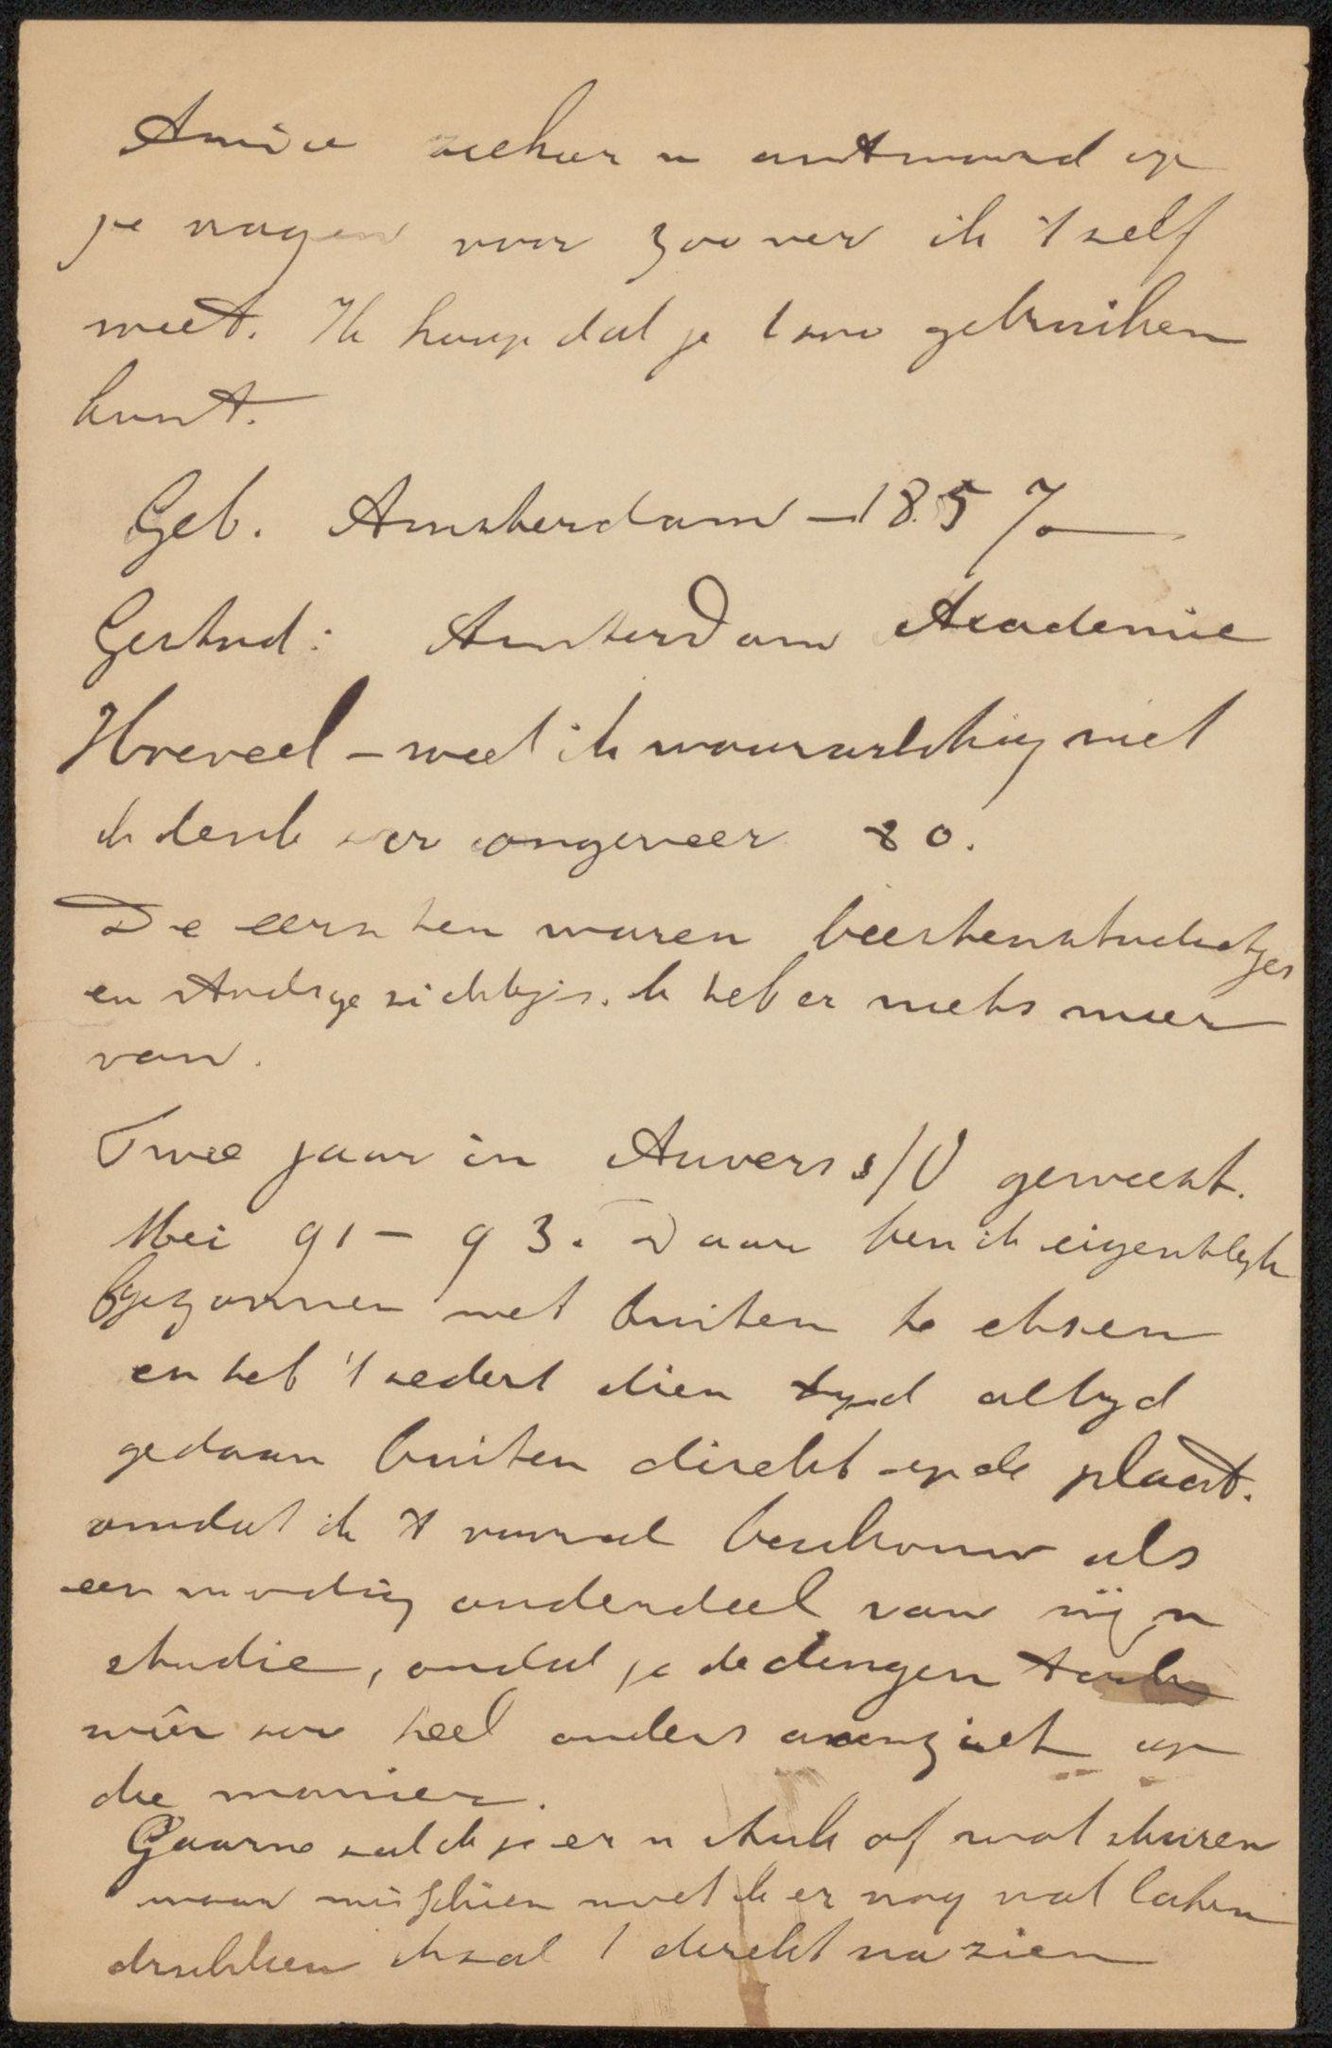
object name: letter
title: Brief aan Philip Zilcken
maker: maurits van der valk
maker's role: draughtsman, print maker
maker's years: 1857-1935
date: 1893-1930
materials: ink, paper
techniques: pen, writing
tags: the hague, painter, draughtsman, philip zilcken, the graphic arts, education, tuition of the artist (in general), amsterdam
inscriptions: watermark, collector's mark: ‘RPK’